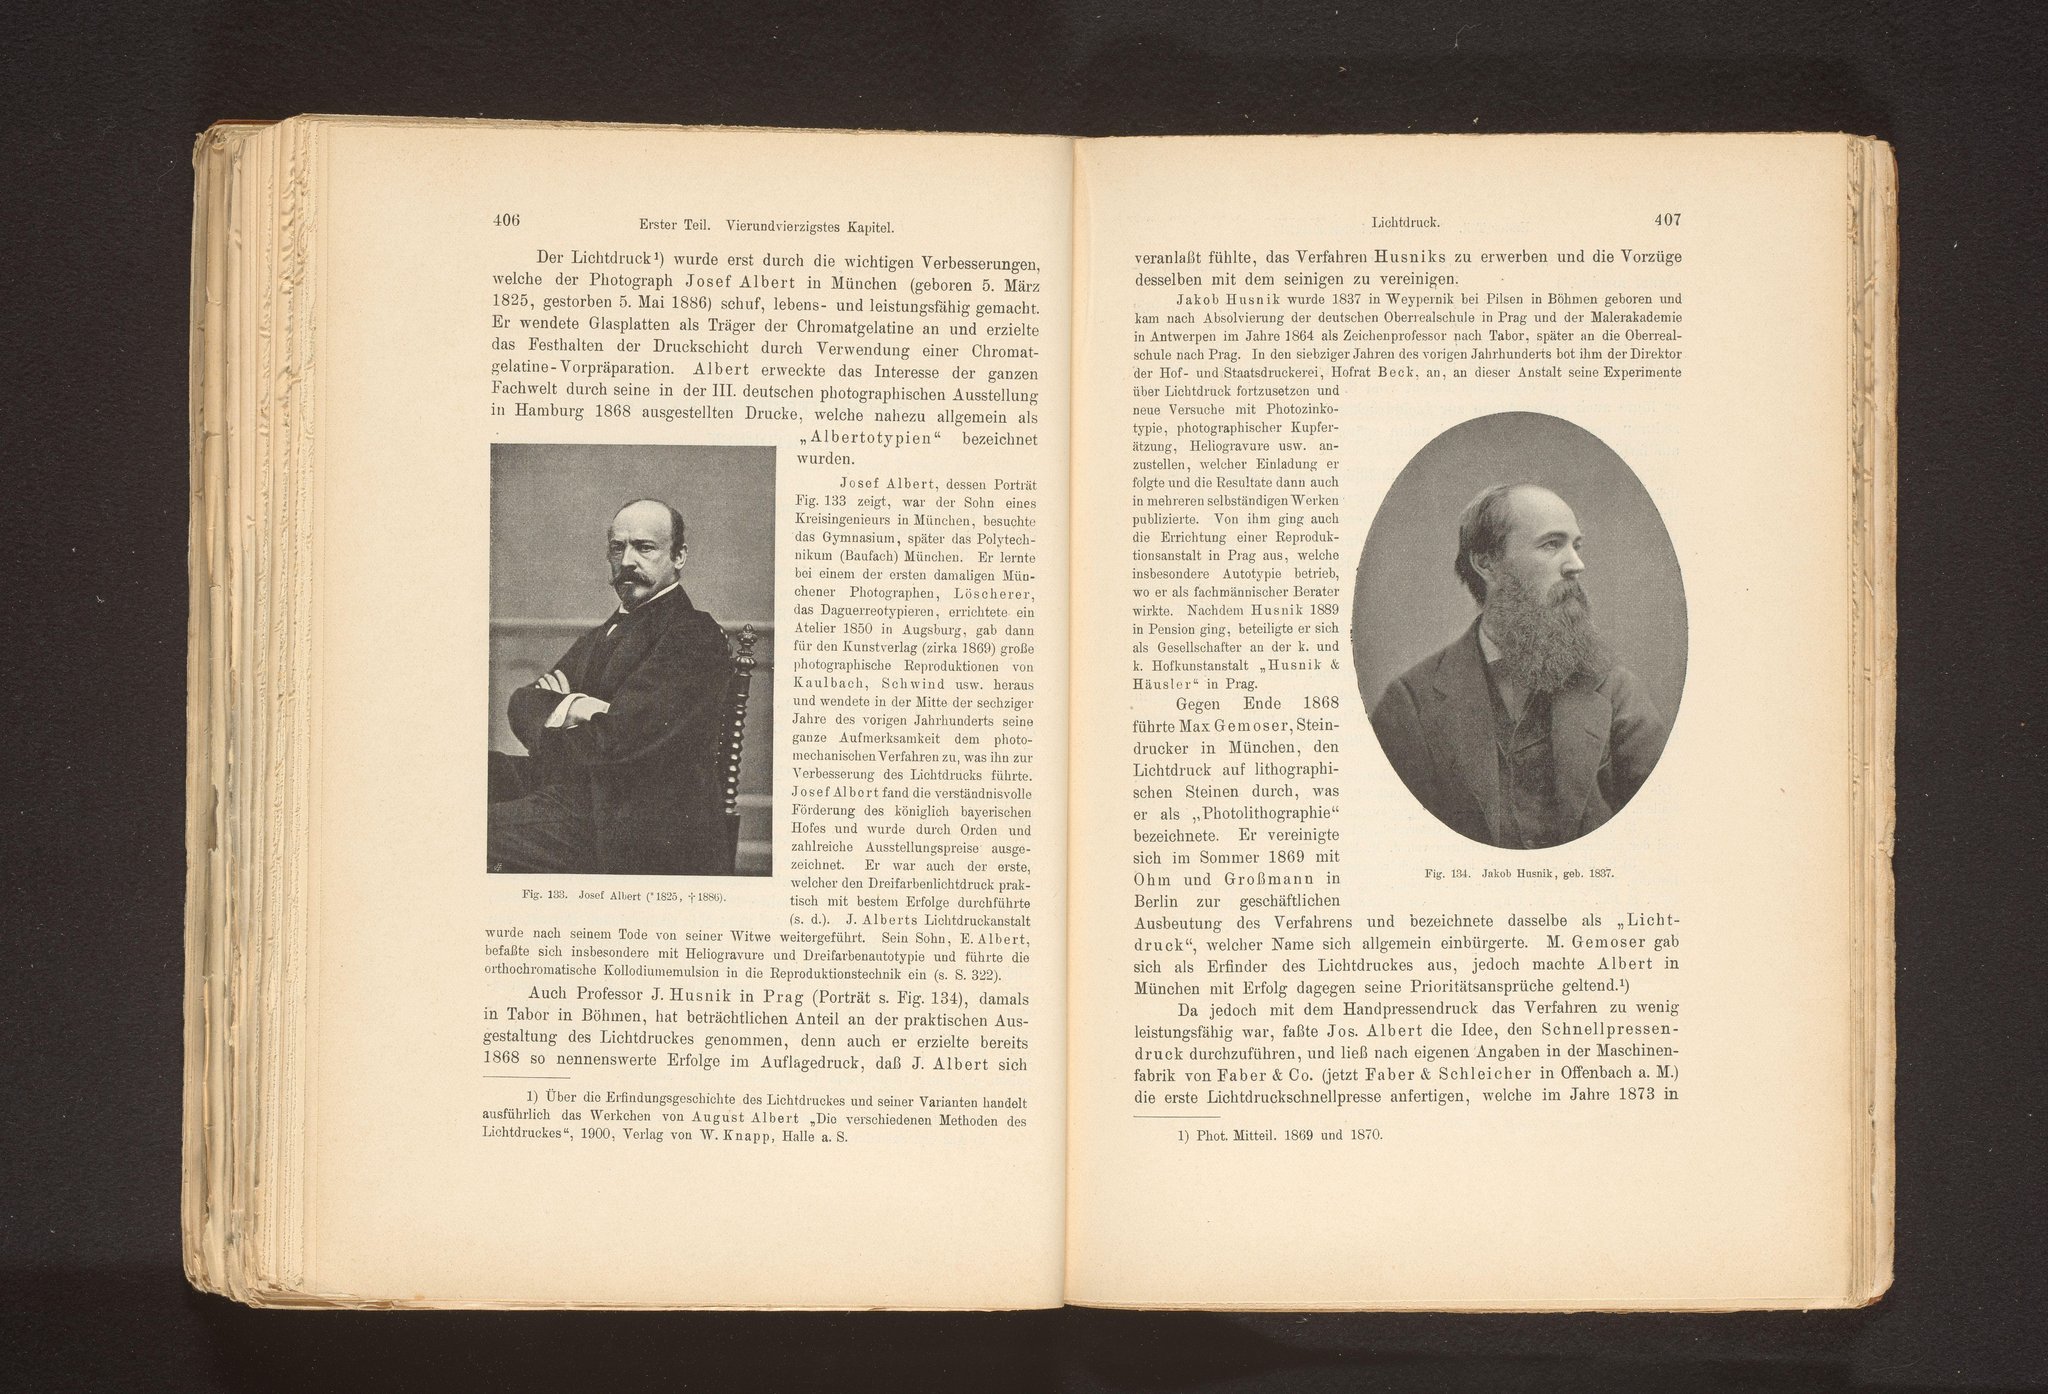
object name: photomechanical print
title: Portret van Joseph Albert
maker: Anonymous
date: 1900-1905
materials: paper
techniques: autotype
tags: publisher, joseph albert, portrait, self-portrait of photographer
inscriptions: number: ‘Fig. 133.’